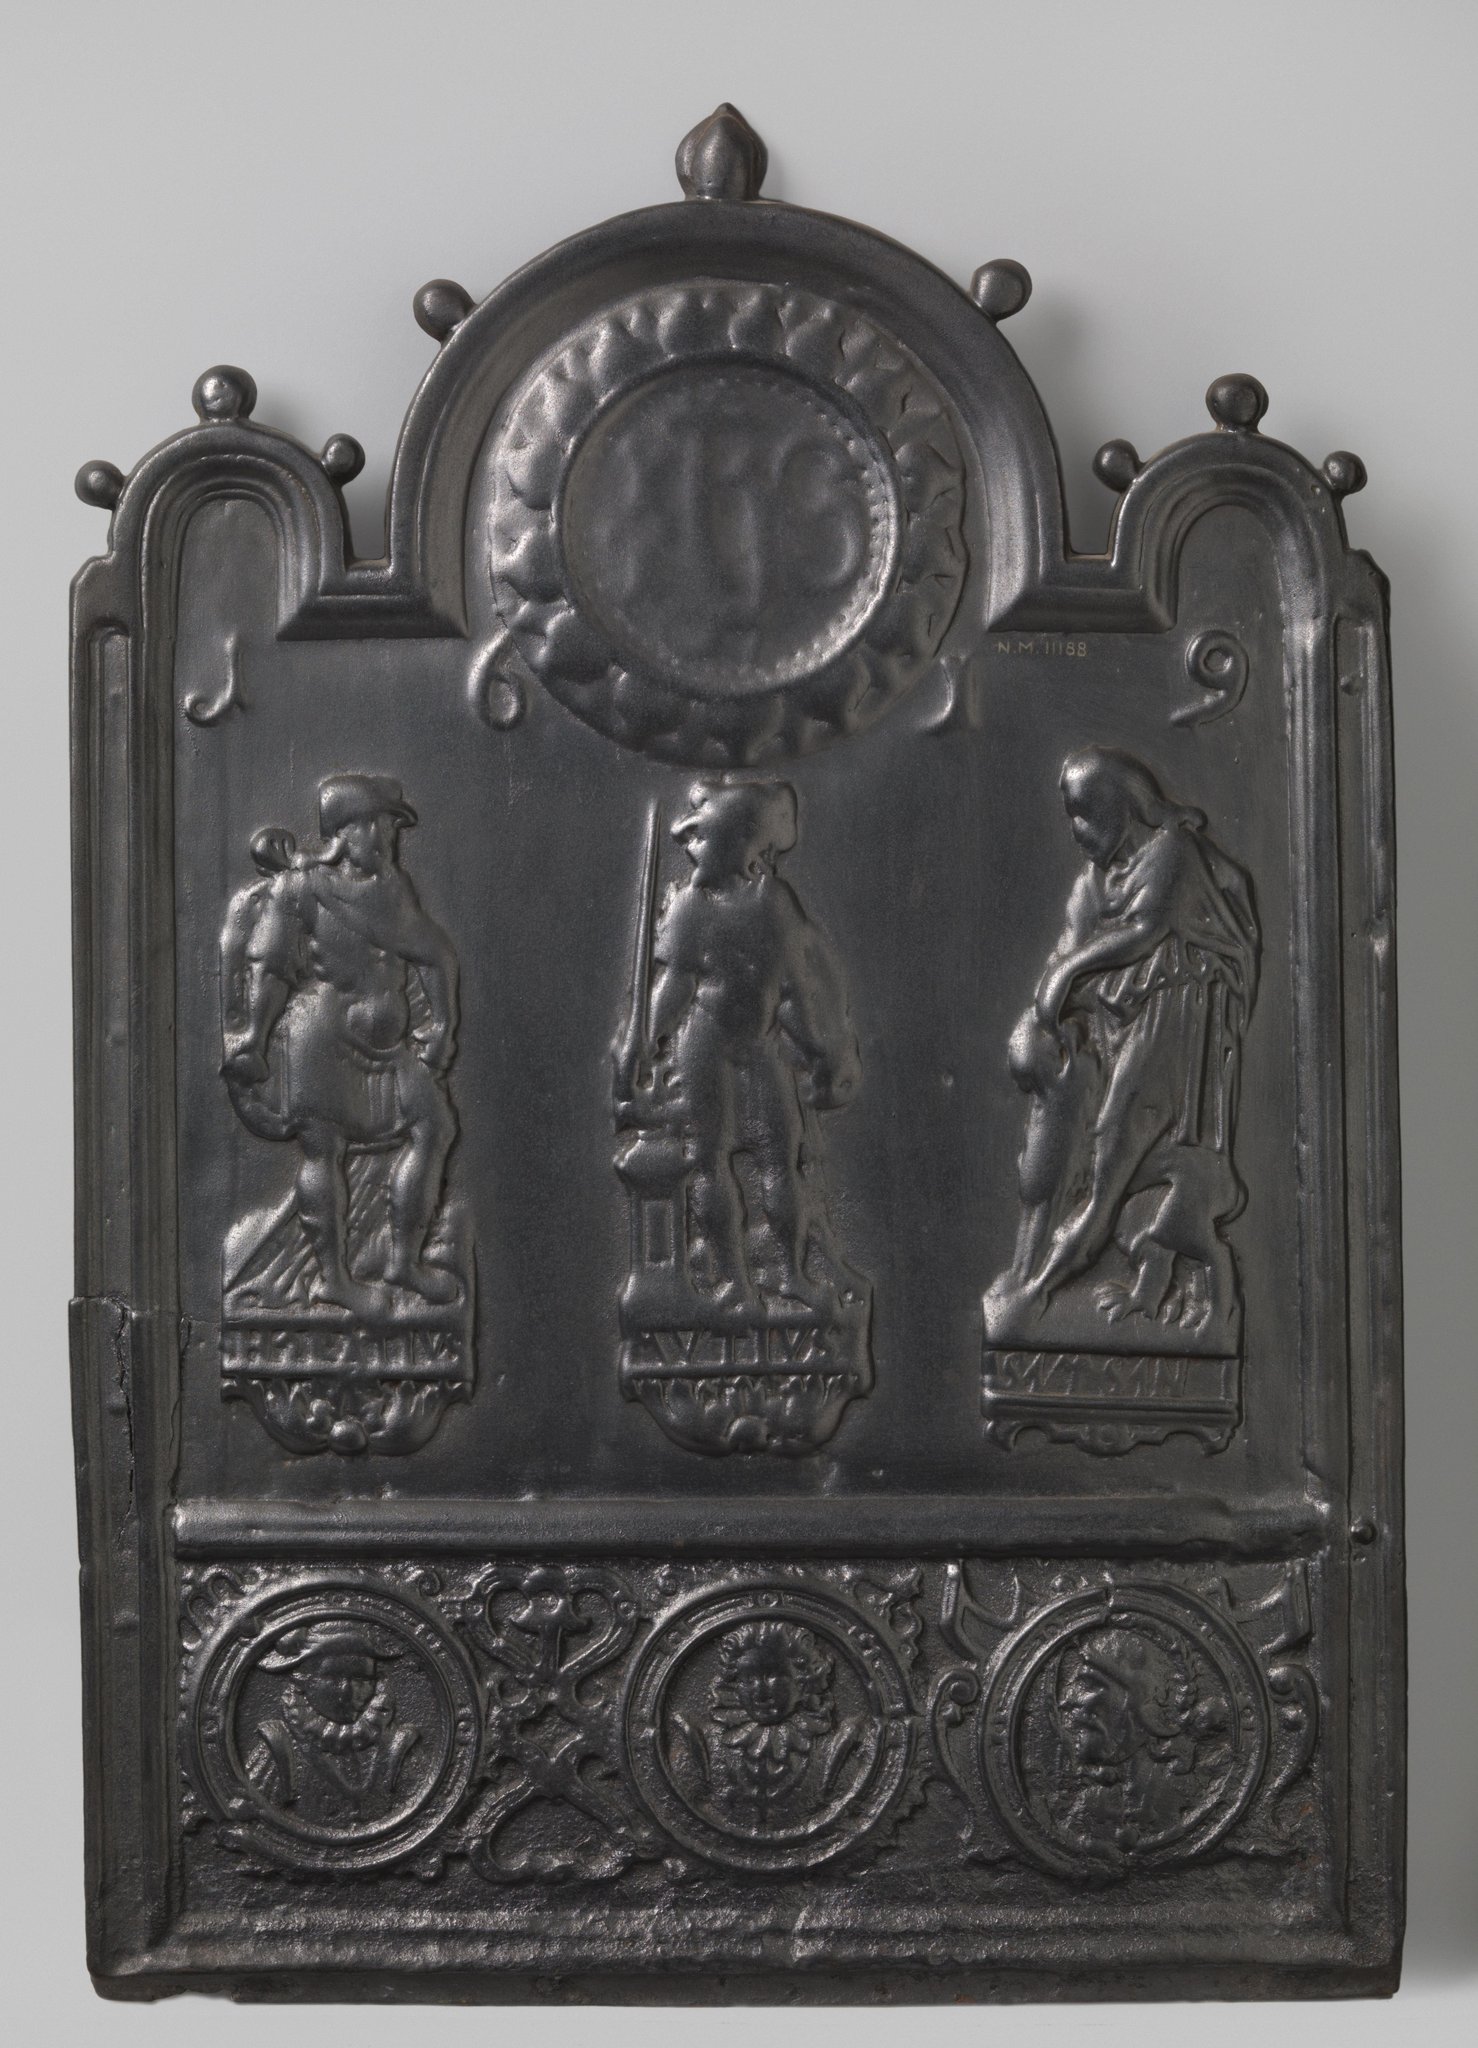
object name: fireback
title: Haardplaat met Horacius, Mutius en Samson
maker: Anonymous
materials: iron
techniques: casting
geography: germany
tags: samson kills the lion with his bare hands, (story of) horatius cocles, (story of) gaius mucius scaevola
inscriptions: inscription: ‘HORATIUS / MUCIUS / SAMSAN’, inscription: ‘1619’, inscription: ‘IHS’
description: Haardplaat van gietijzer, bestaande uit twee zones. In de bovenste zone is bovenaan een medaillon met de letters IHS en direct daaronder het jaartal 1619. Daaronder drie mannelijke figuren staande op een console met hun naam, respectievelijk Horatius Cocles, Gaius Mucius Scaevola en Samson. In de onderste zone drie medaillons met bustes gescheiden van elkaar door rankwerk. De twee linkse medaillons tonen een buste en face, met links een man en rechts een vrouw. Het rechter medaillon toont de buste van een man en profil. Alle figuren en medaillons zijn afkomstig van afzonderlijke modellen. De bovenzijde van de haardplaat is drielobbig en is versierd met ronde knoppen.